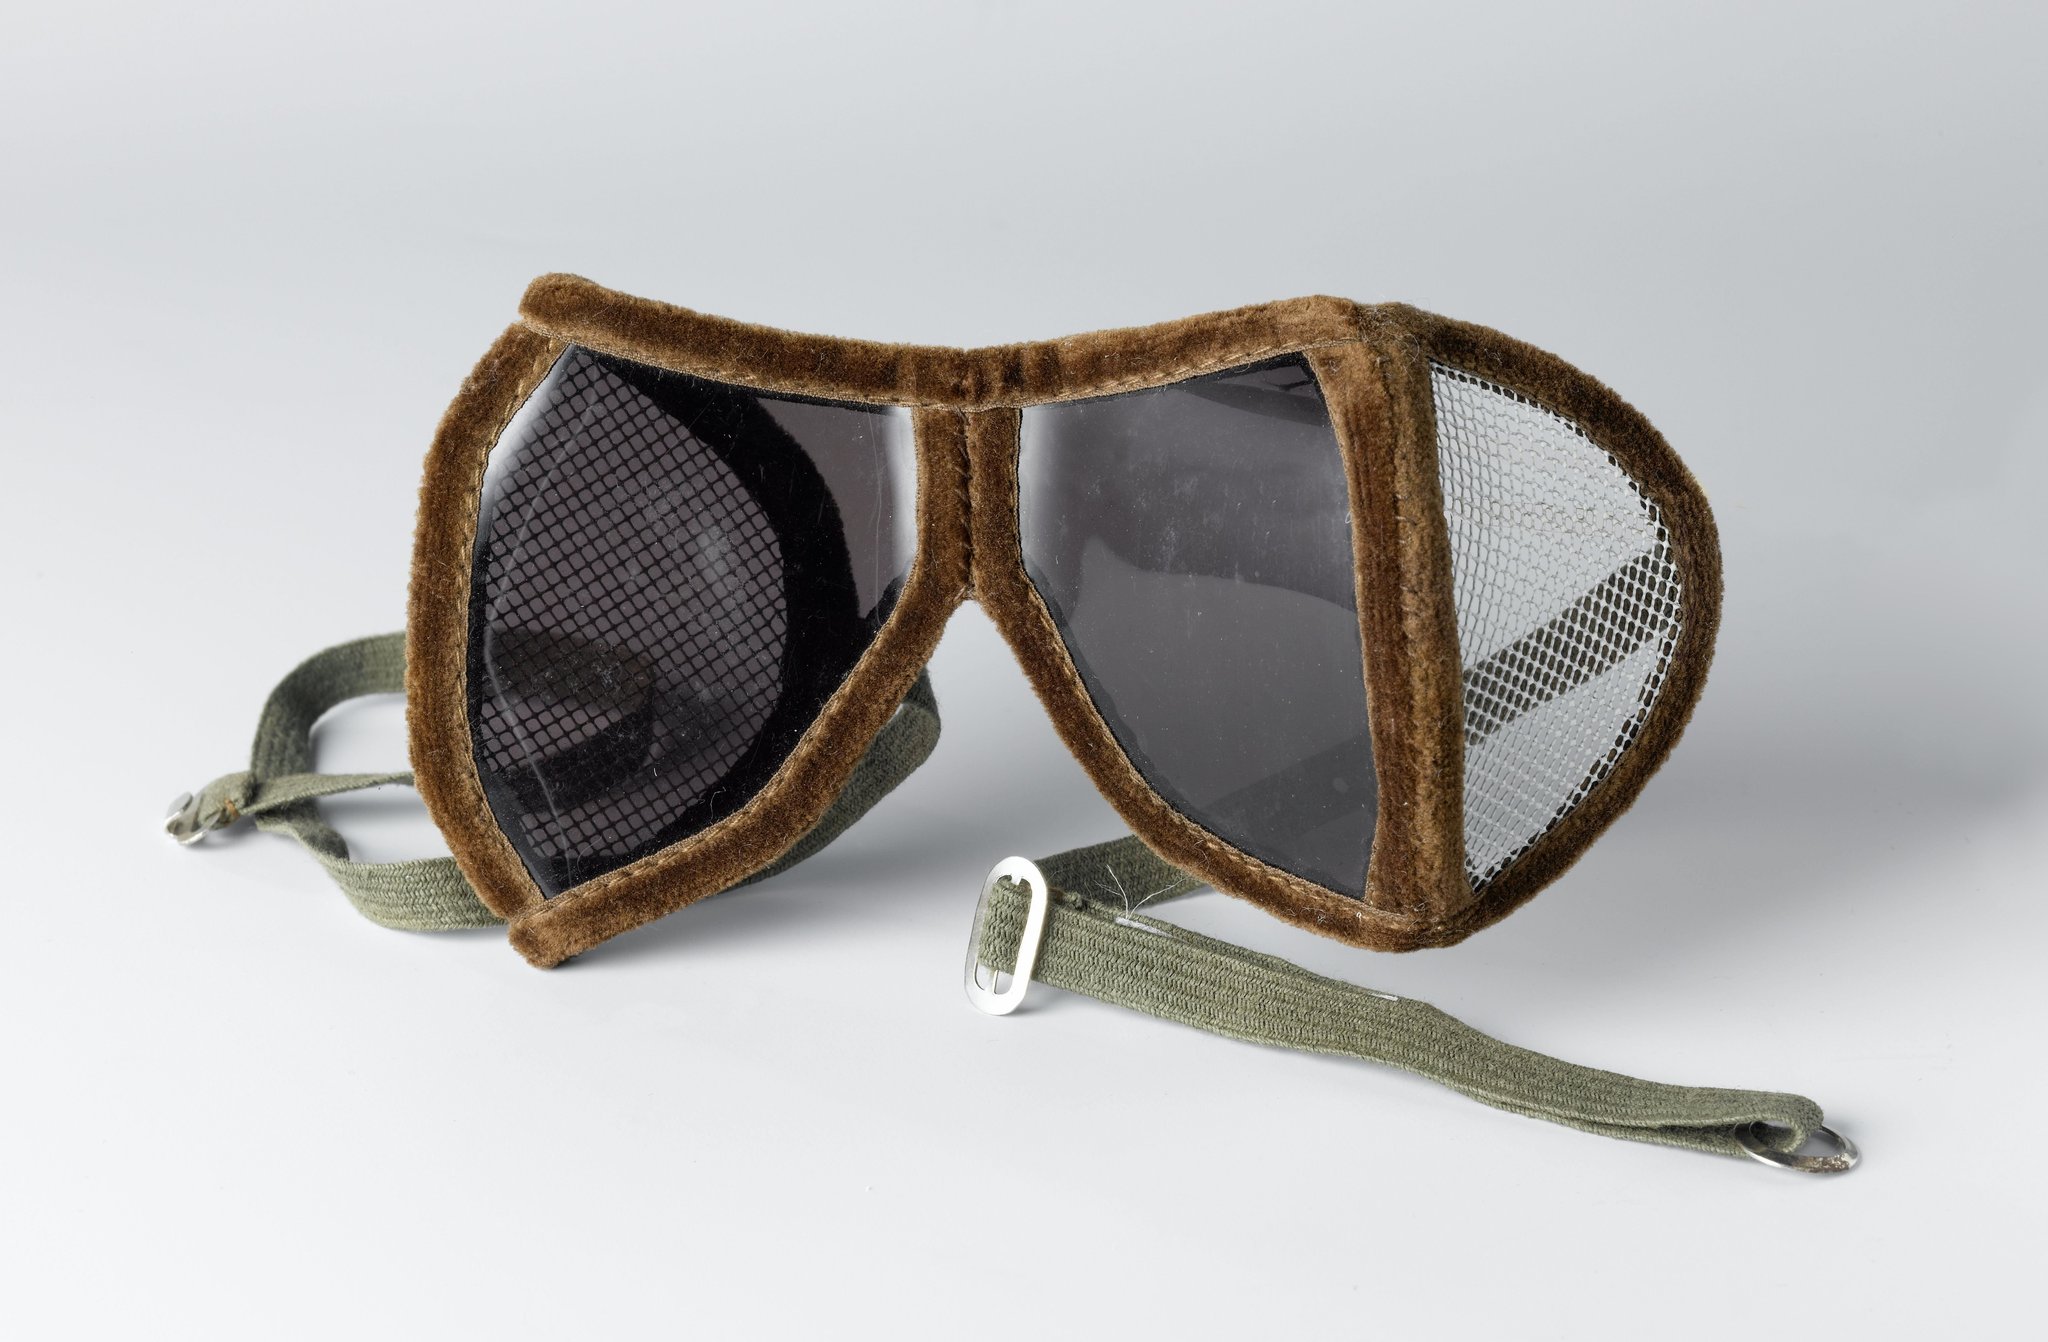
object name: goggles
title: Bril met montuur van fluweel, glazen van mica of kunststof en band van elastiek met haaksluiting van metaal, voor in de auto of op de motor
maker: Anonymous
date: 1900-1920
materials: metal, silk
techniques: cutting, weave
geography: netherlands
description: Bril met montuur van fluweel, glazen van mica of kunststof en band van elastiek met haaksluiting van metaal, voor in de auto of op de motor. Aan weerskanten van de glazen een extra paneel met wit gelakt metalen? gaas. Sluiting op het achterhoofd aan de elastiek band met metalen haak en oog.